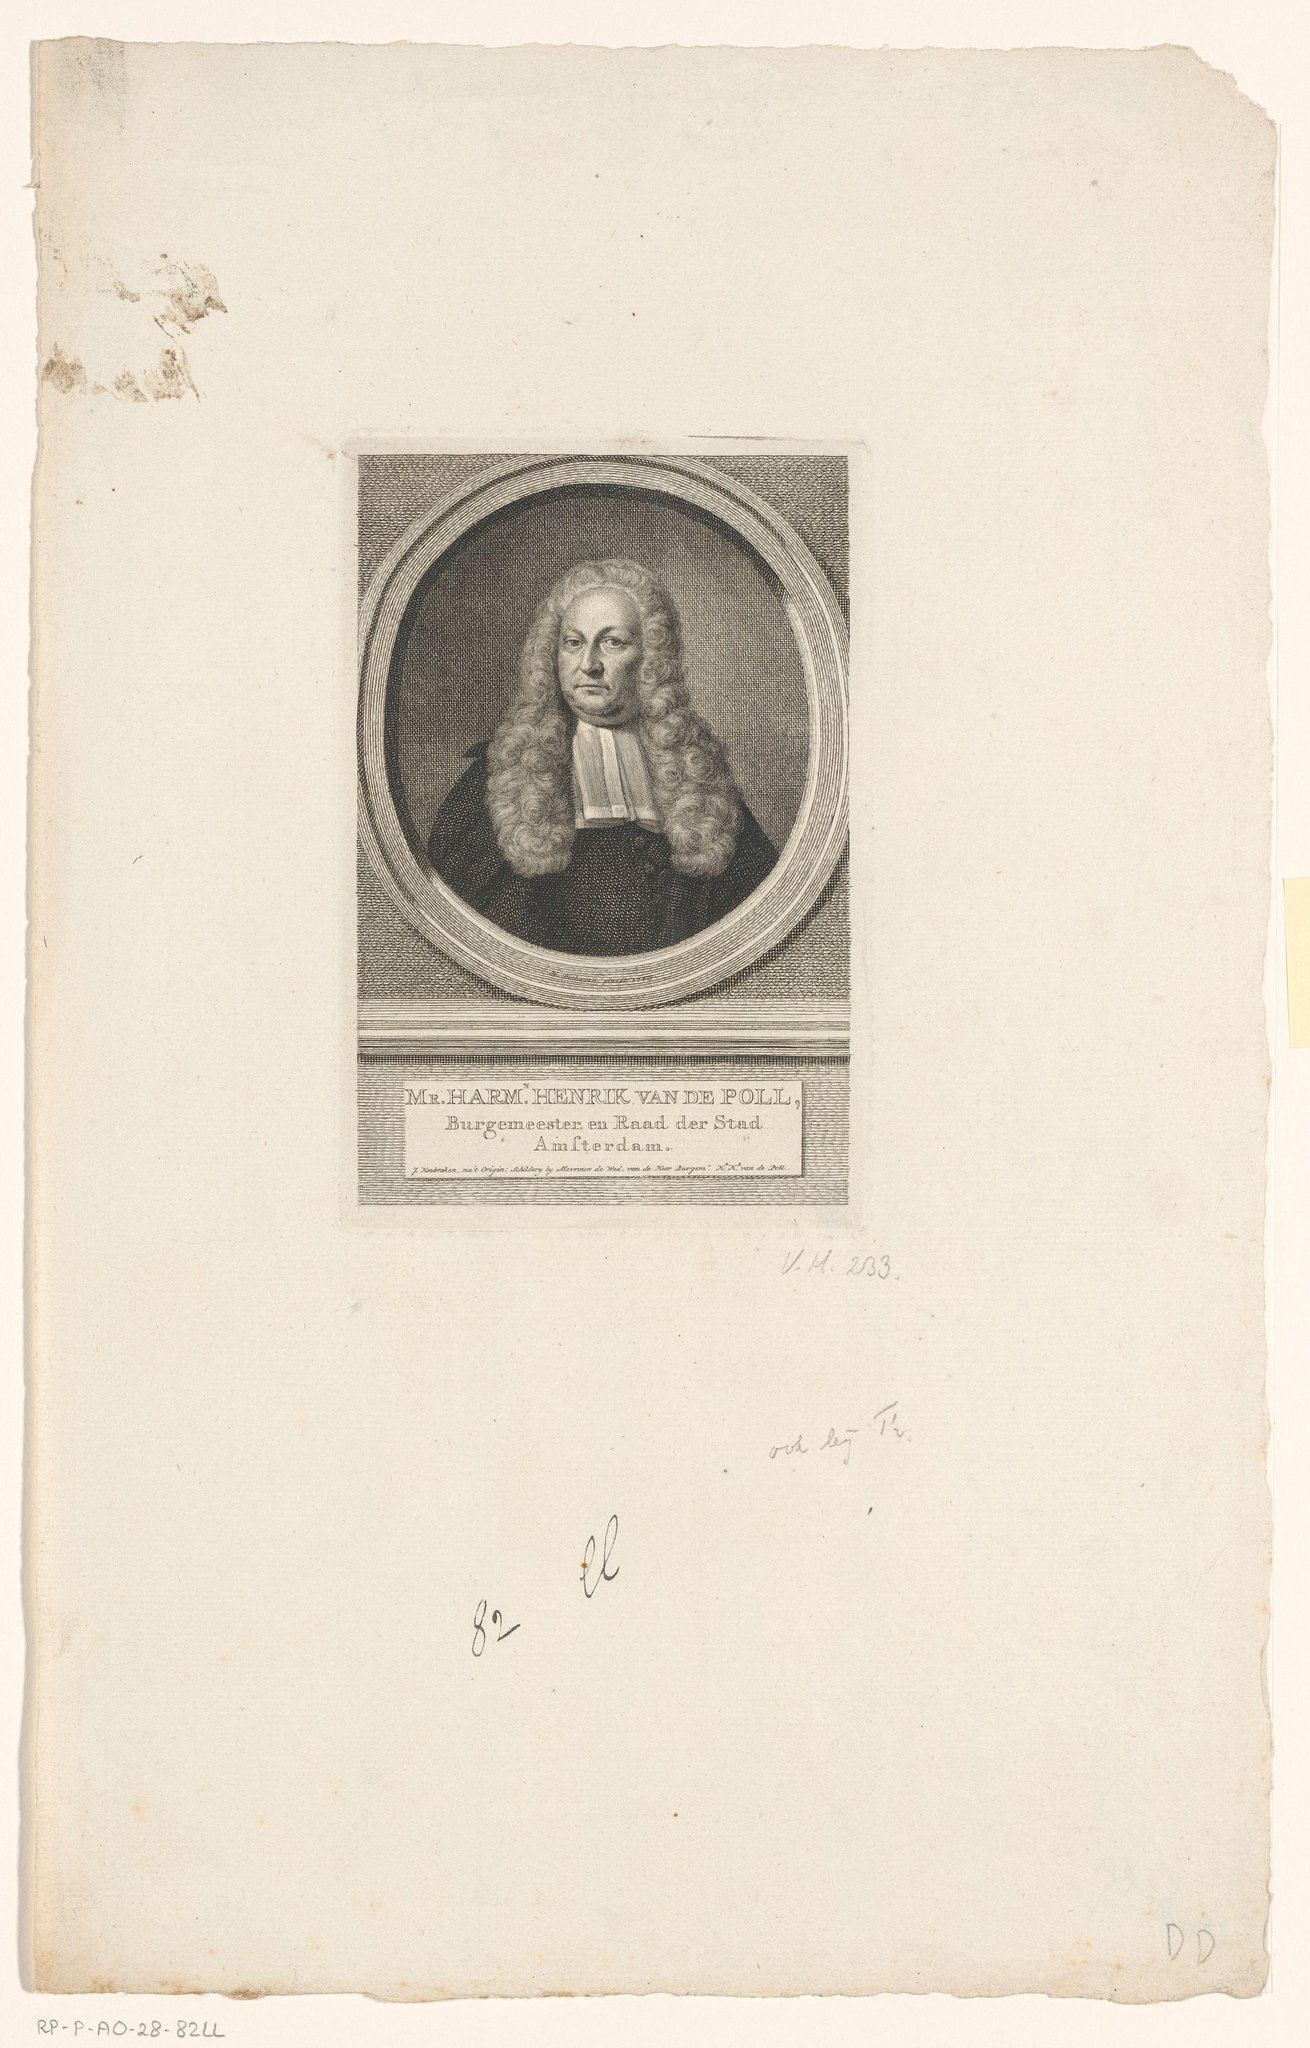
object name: print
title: Portret van Harmen Henrik van de Poll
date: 1772-1780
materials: paper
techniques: engraving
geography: amsterdam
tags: mayor, historical persons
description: Portret van de Amsterdamse burgemeester Harmen Henrik van de Poll in een ovaal. Het portret rust op een plint met daarop zijn naam en gegevens in drie regels in het Nederlands.